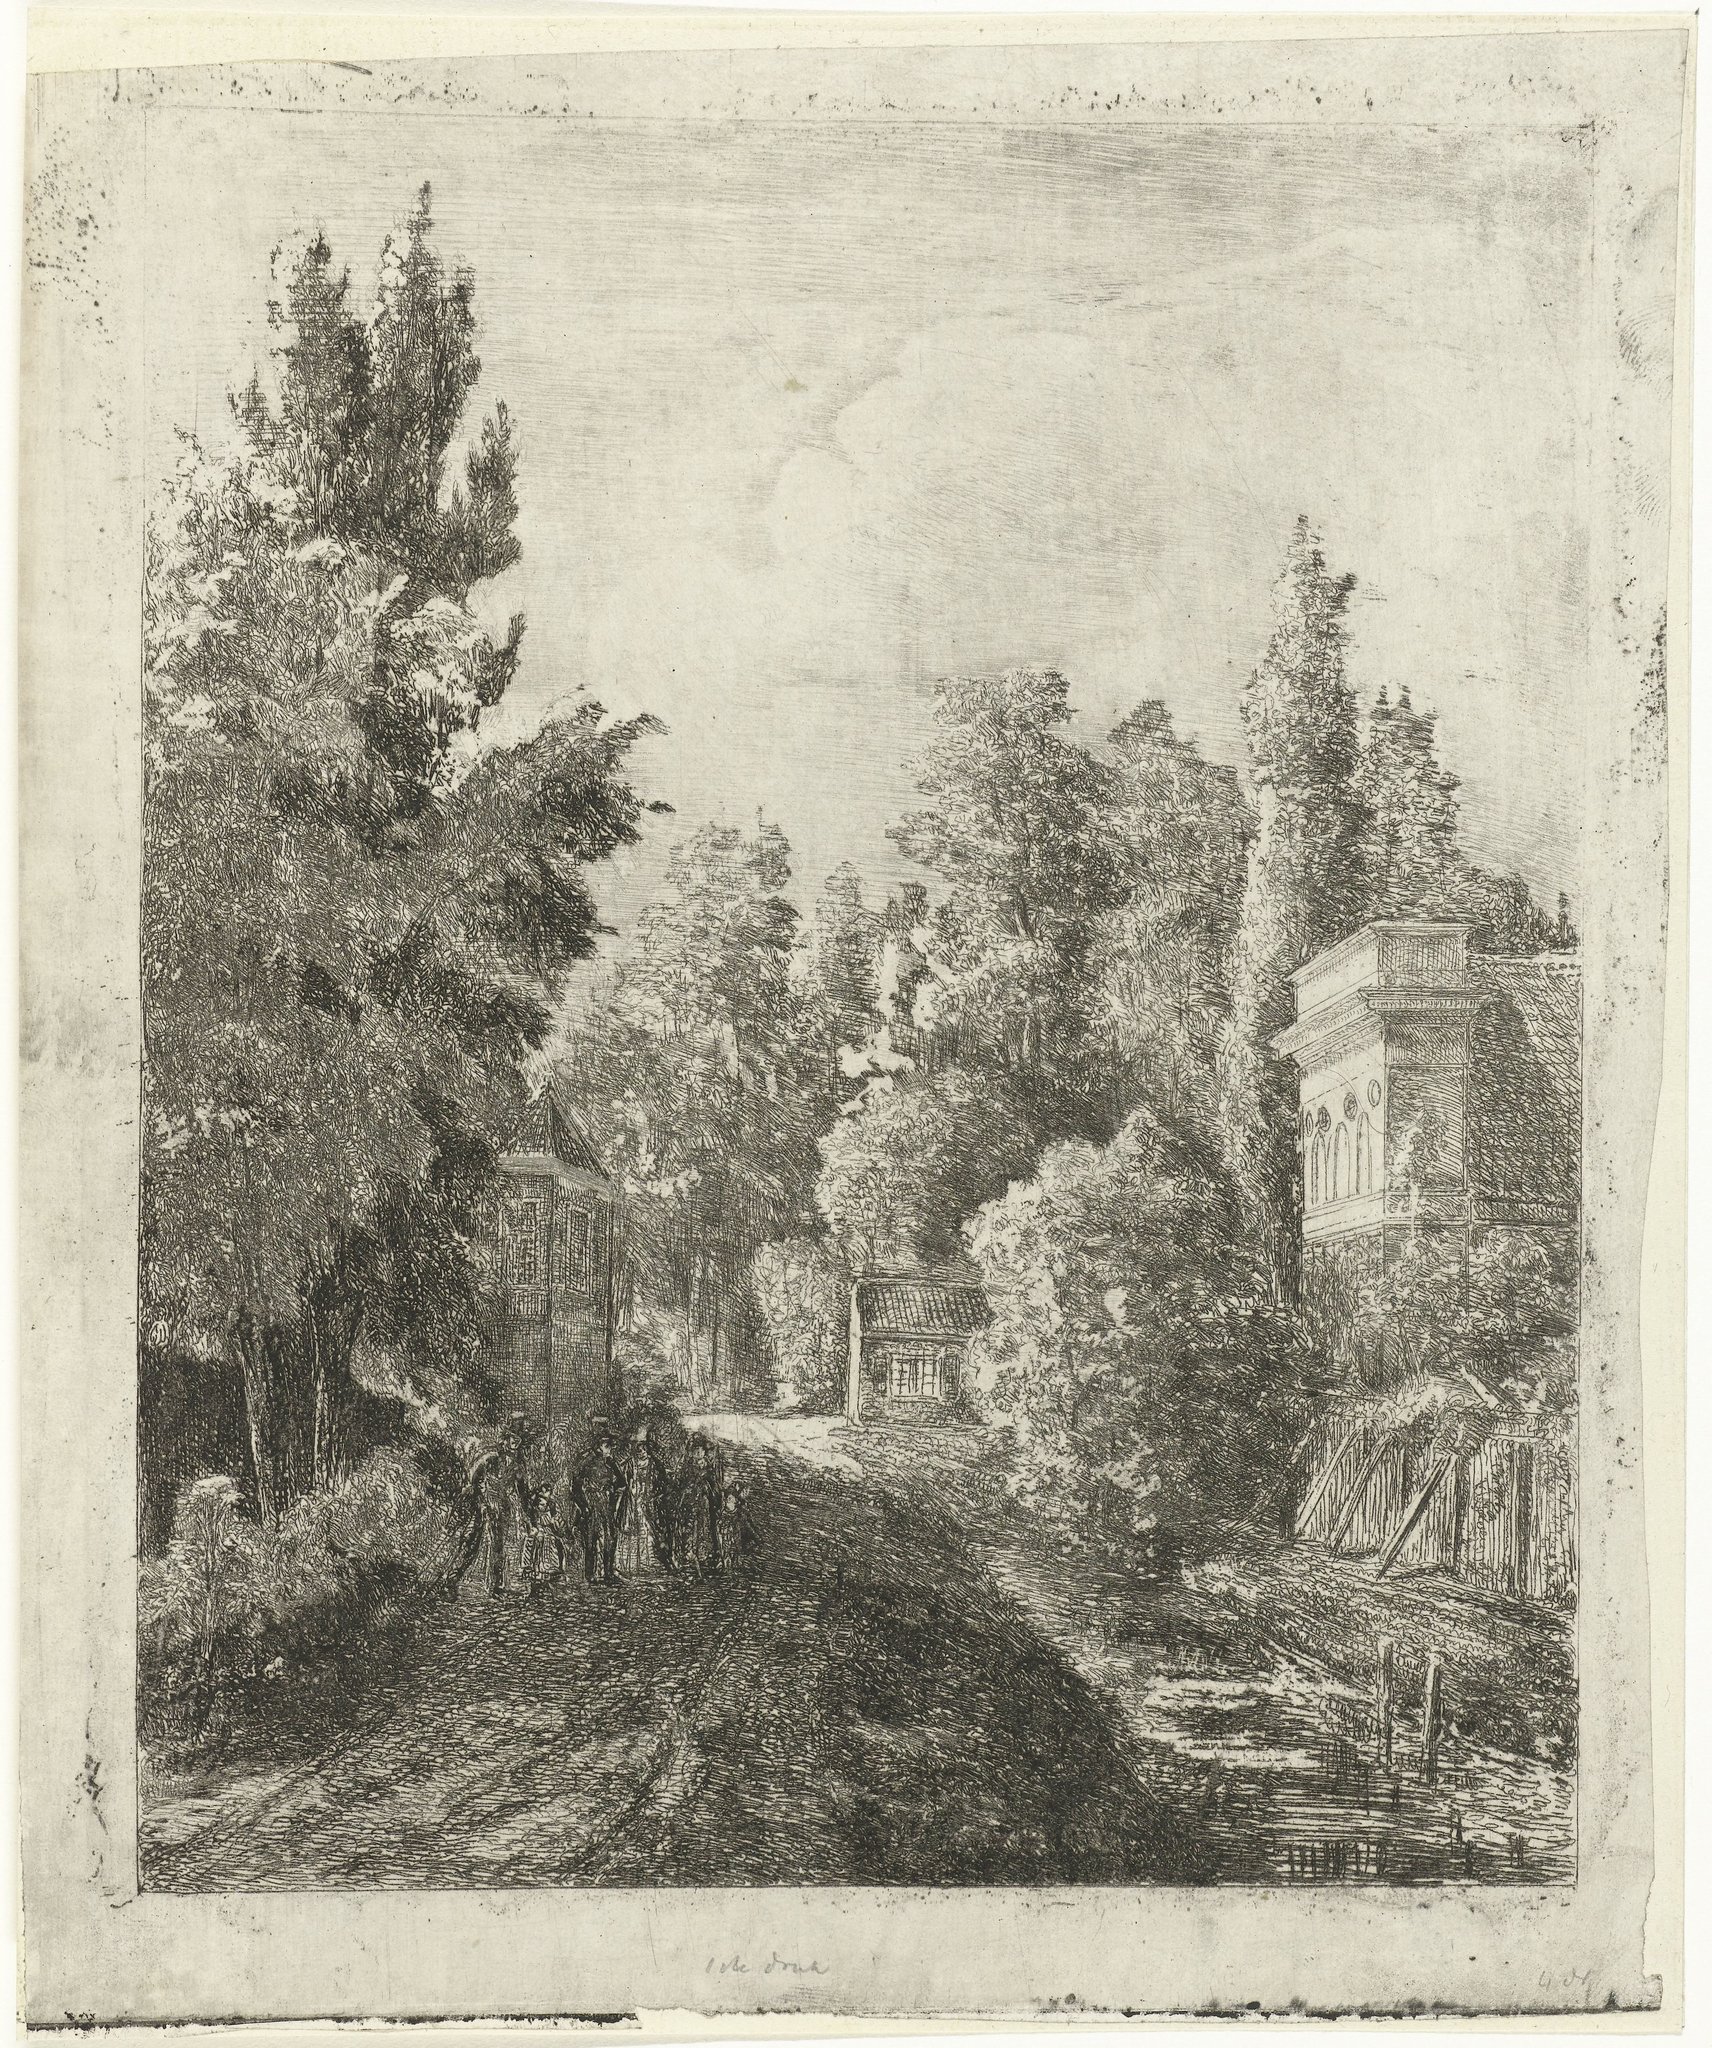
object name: print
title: Dorpsstraat met een wandelend gezelschap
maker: johannes adrianus van der drift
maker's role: print maker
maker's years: 1808-1883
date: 1823-1883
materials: paper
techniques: etching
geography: netherlands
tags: village lane, alley (+ city(-scape) with figures, staffage)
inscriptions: collector's mark: Lugt 2228